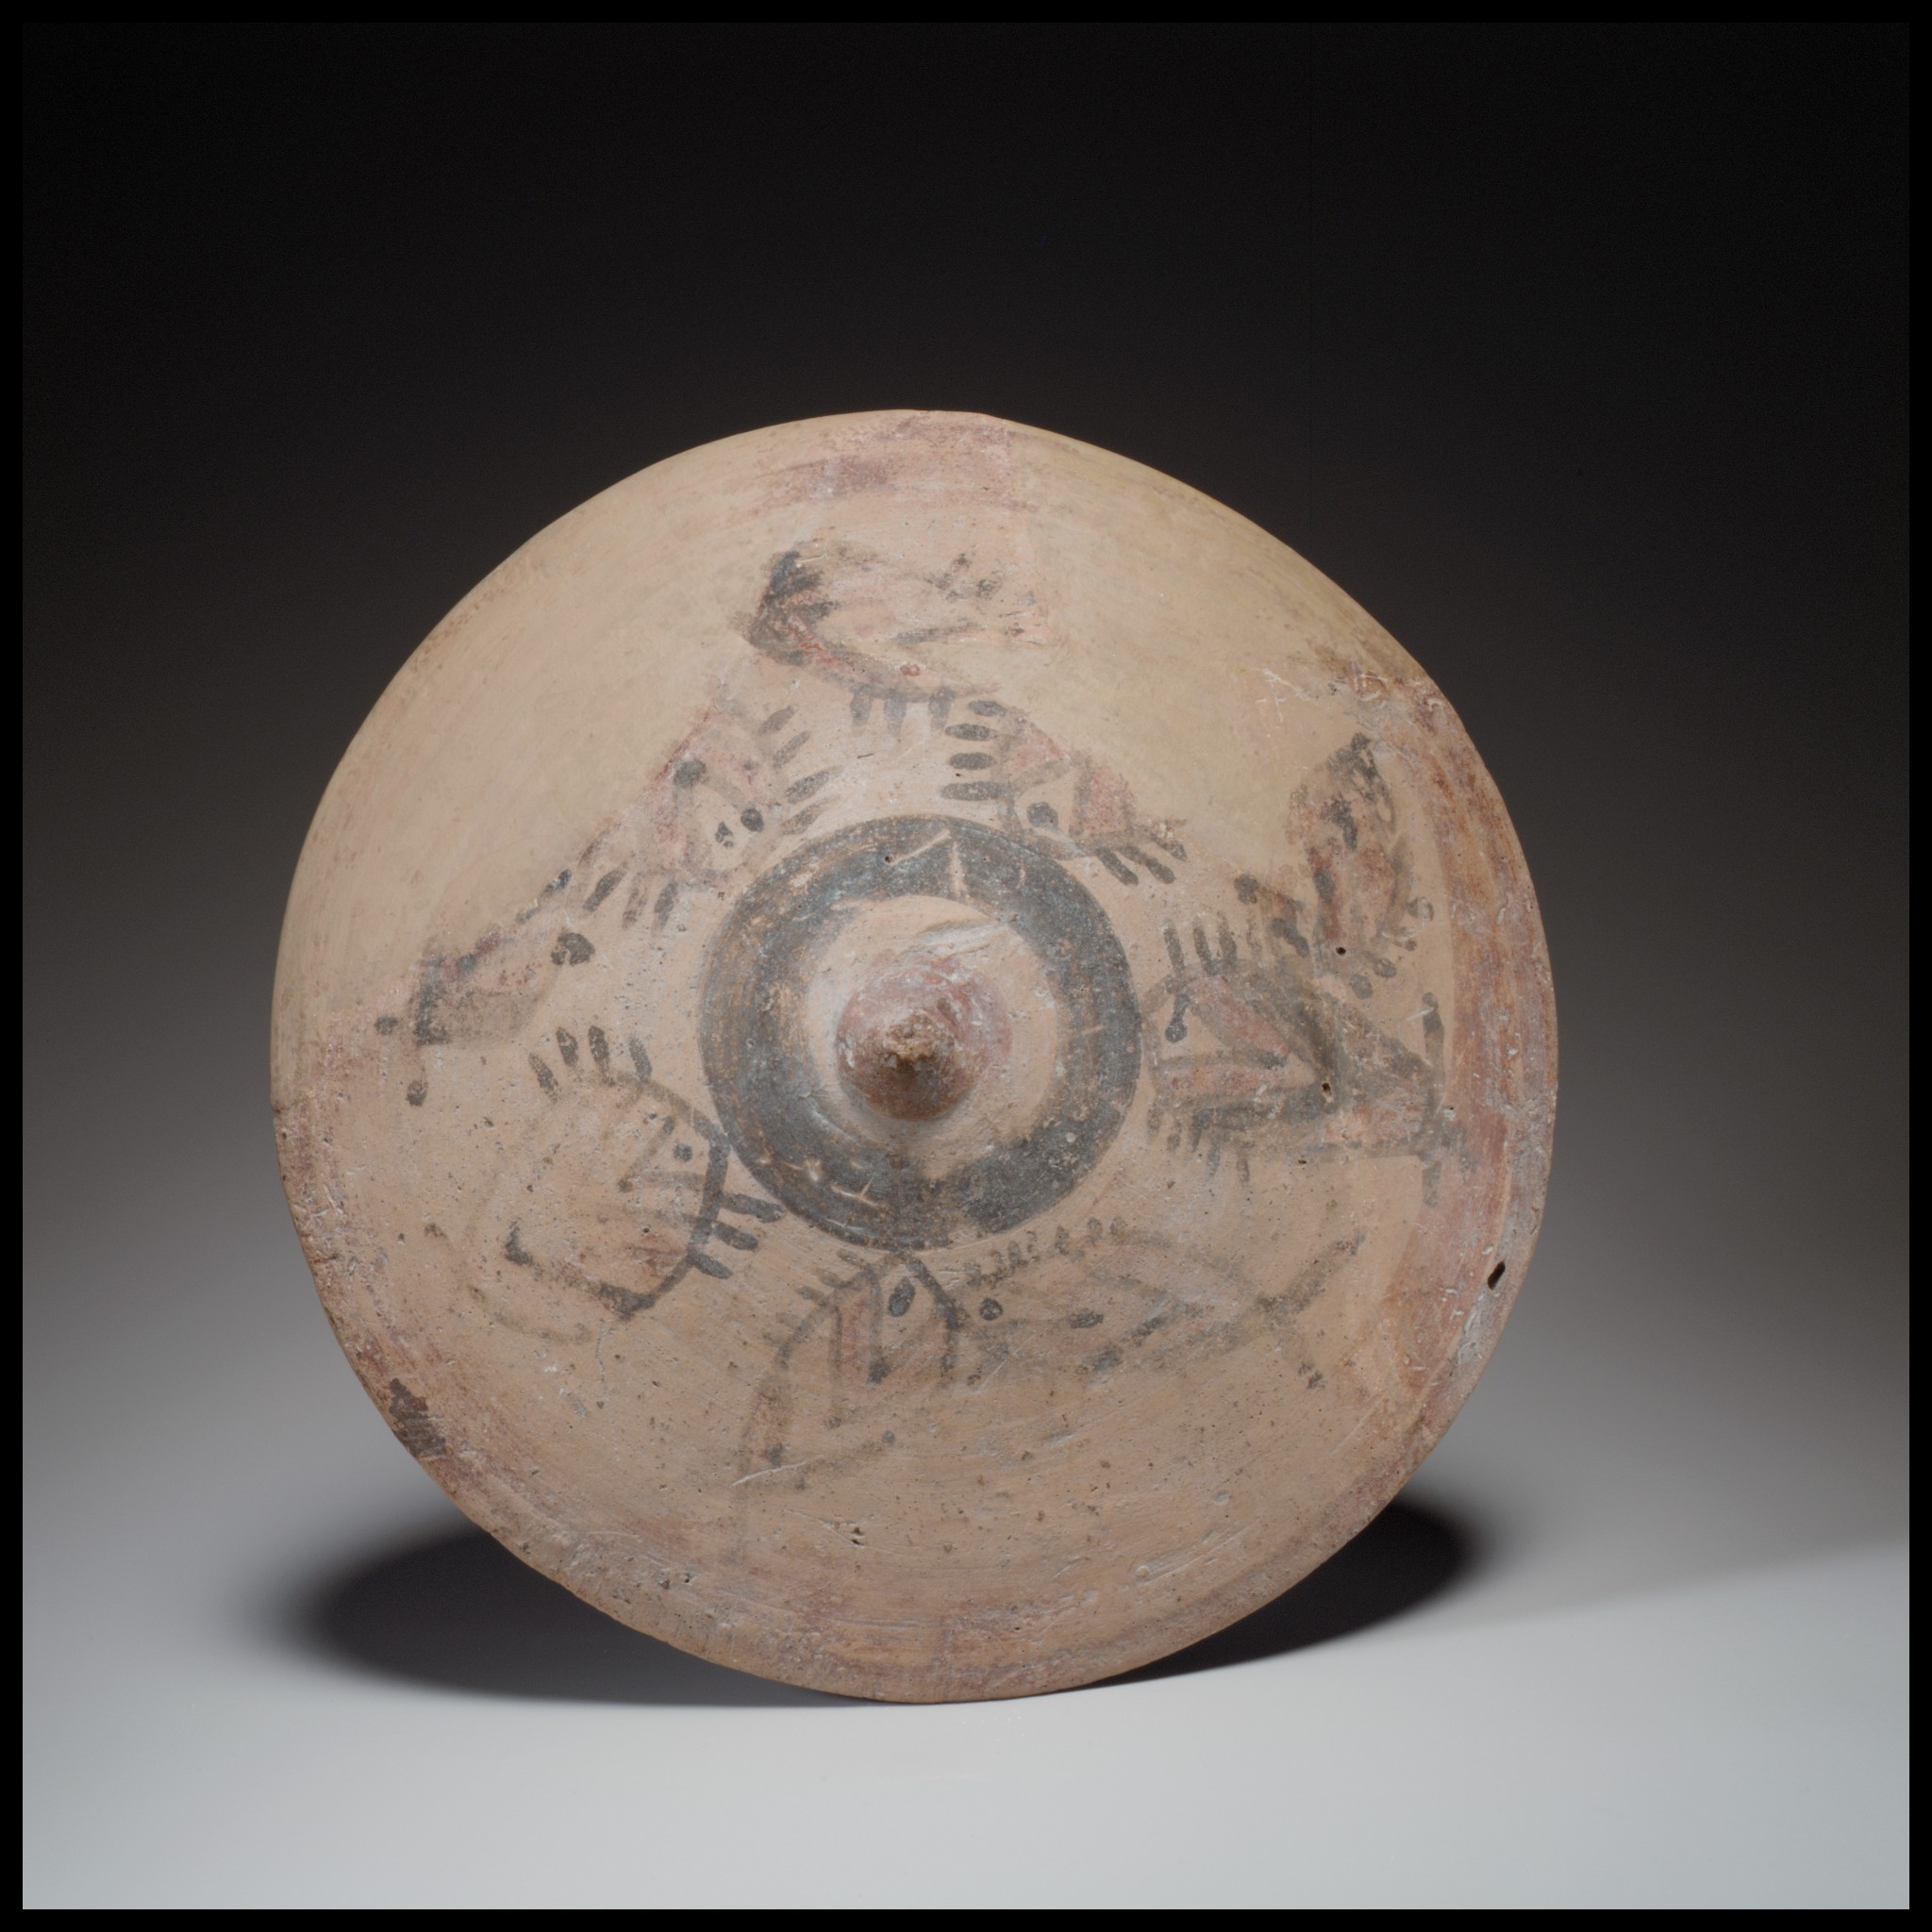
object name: shield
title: Votive shield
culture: cypriot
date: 600-480 BCE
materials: terracotta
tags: shields,fish